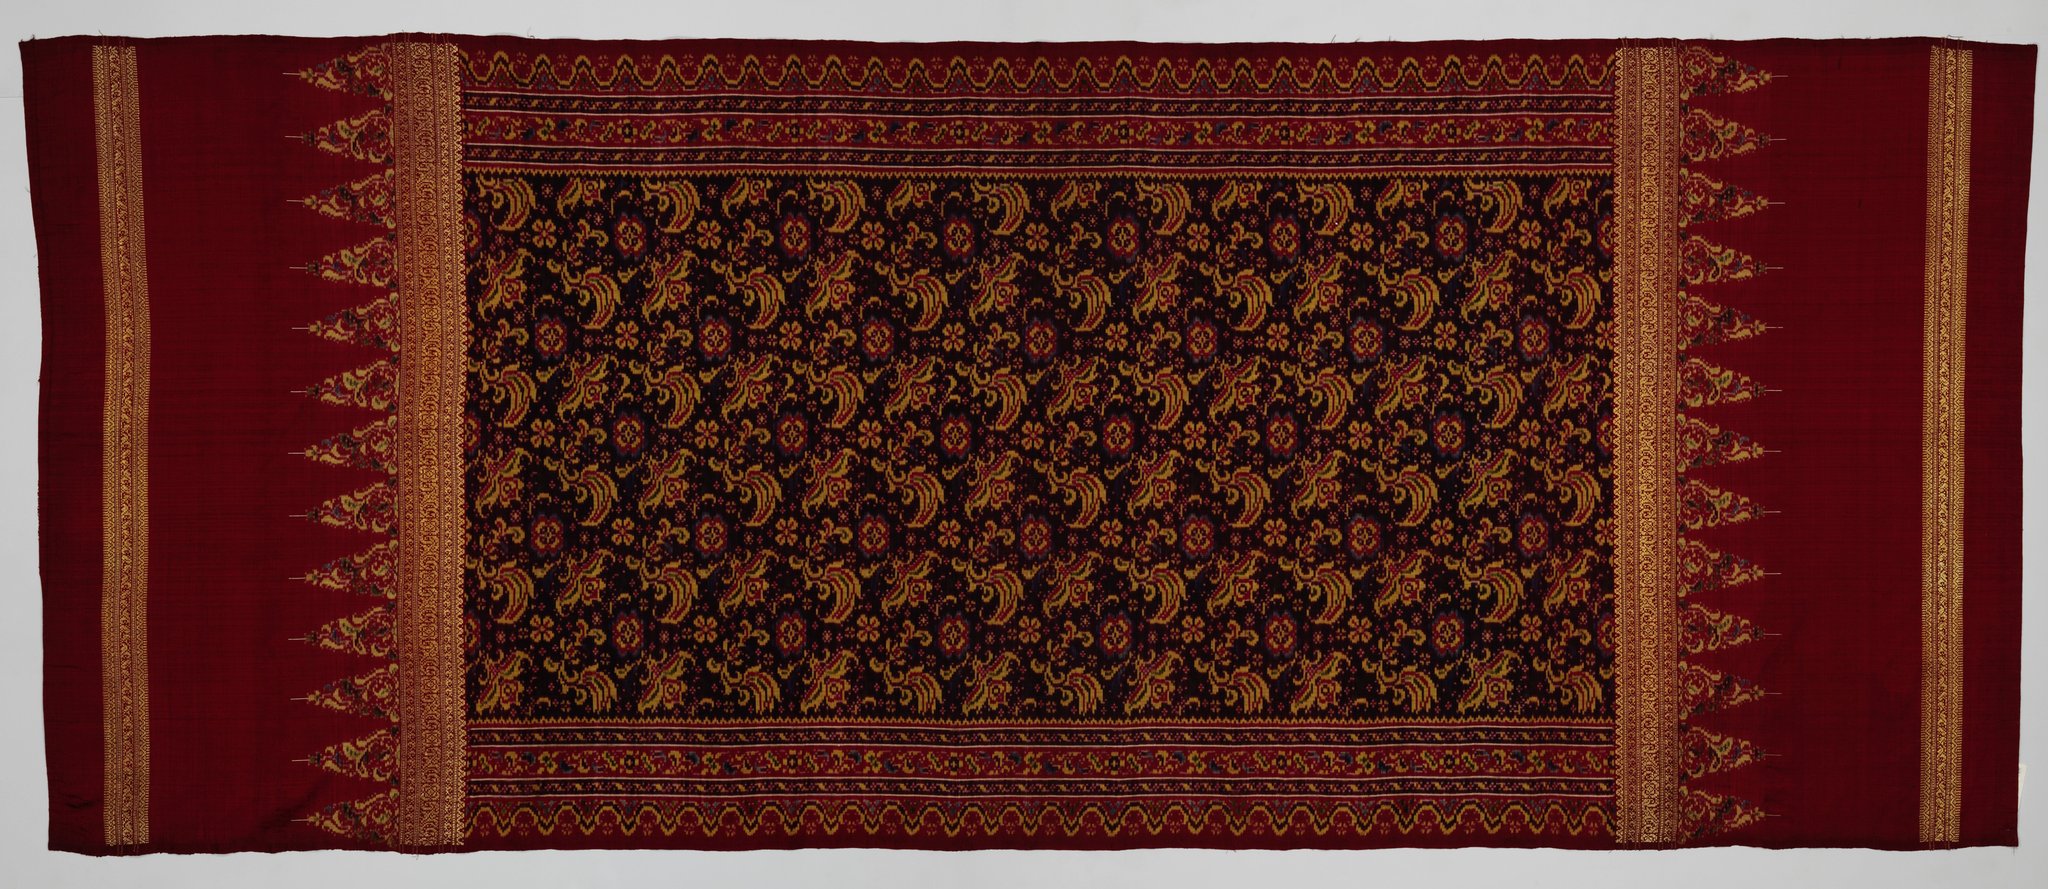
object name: schouderdoek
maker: Anonymous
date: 1900-1999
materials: silk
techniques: weave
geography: muntok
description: Schouderdoek met florale en lar motieven.